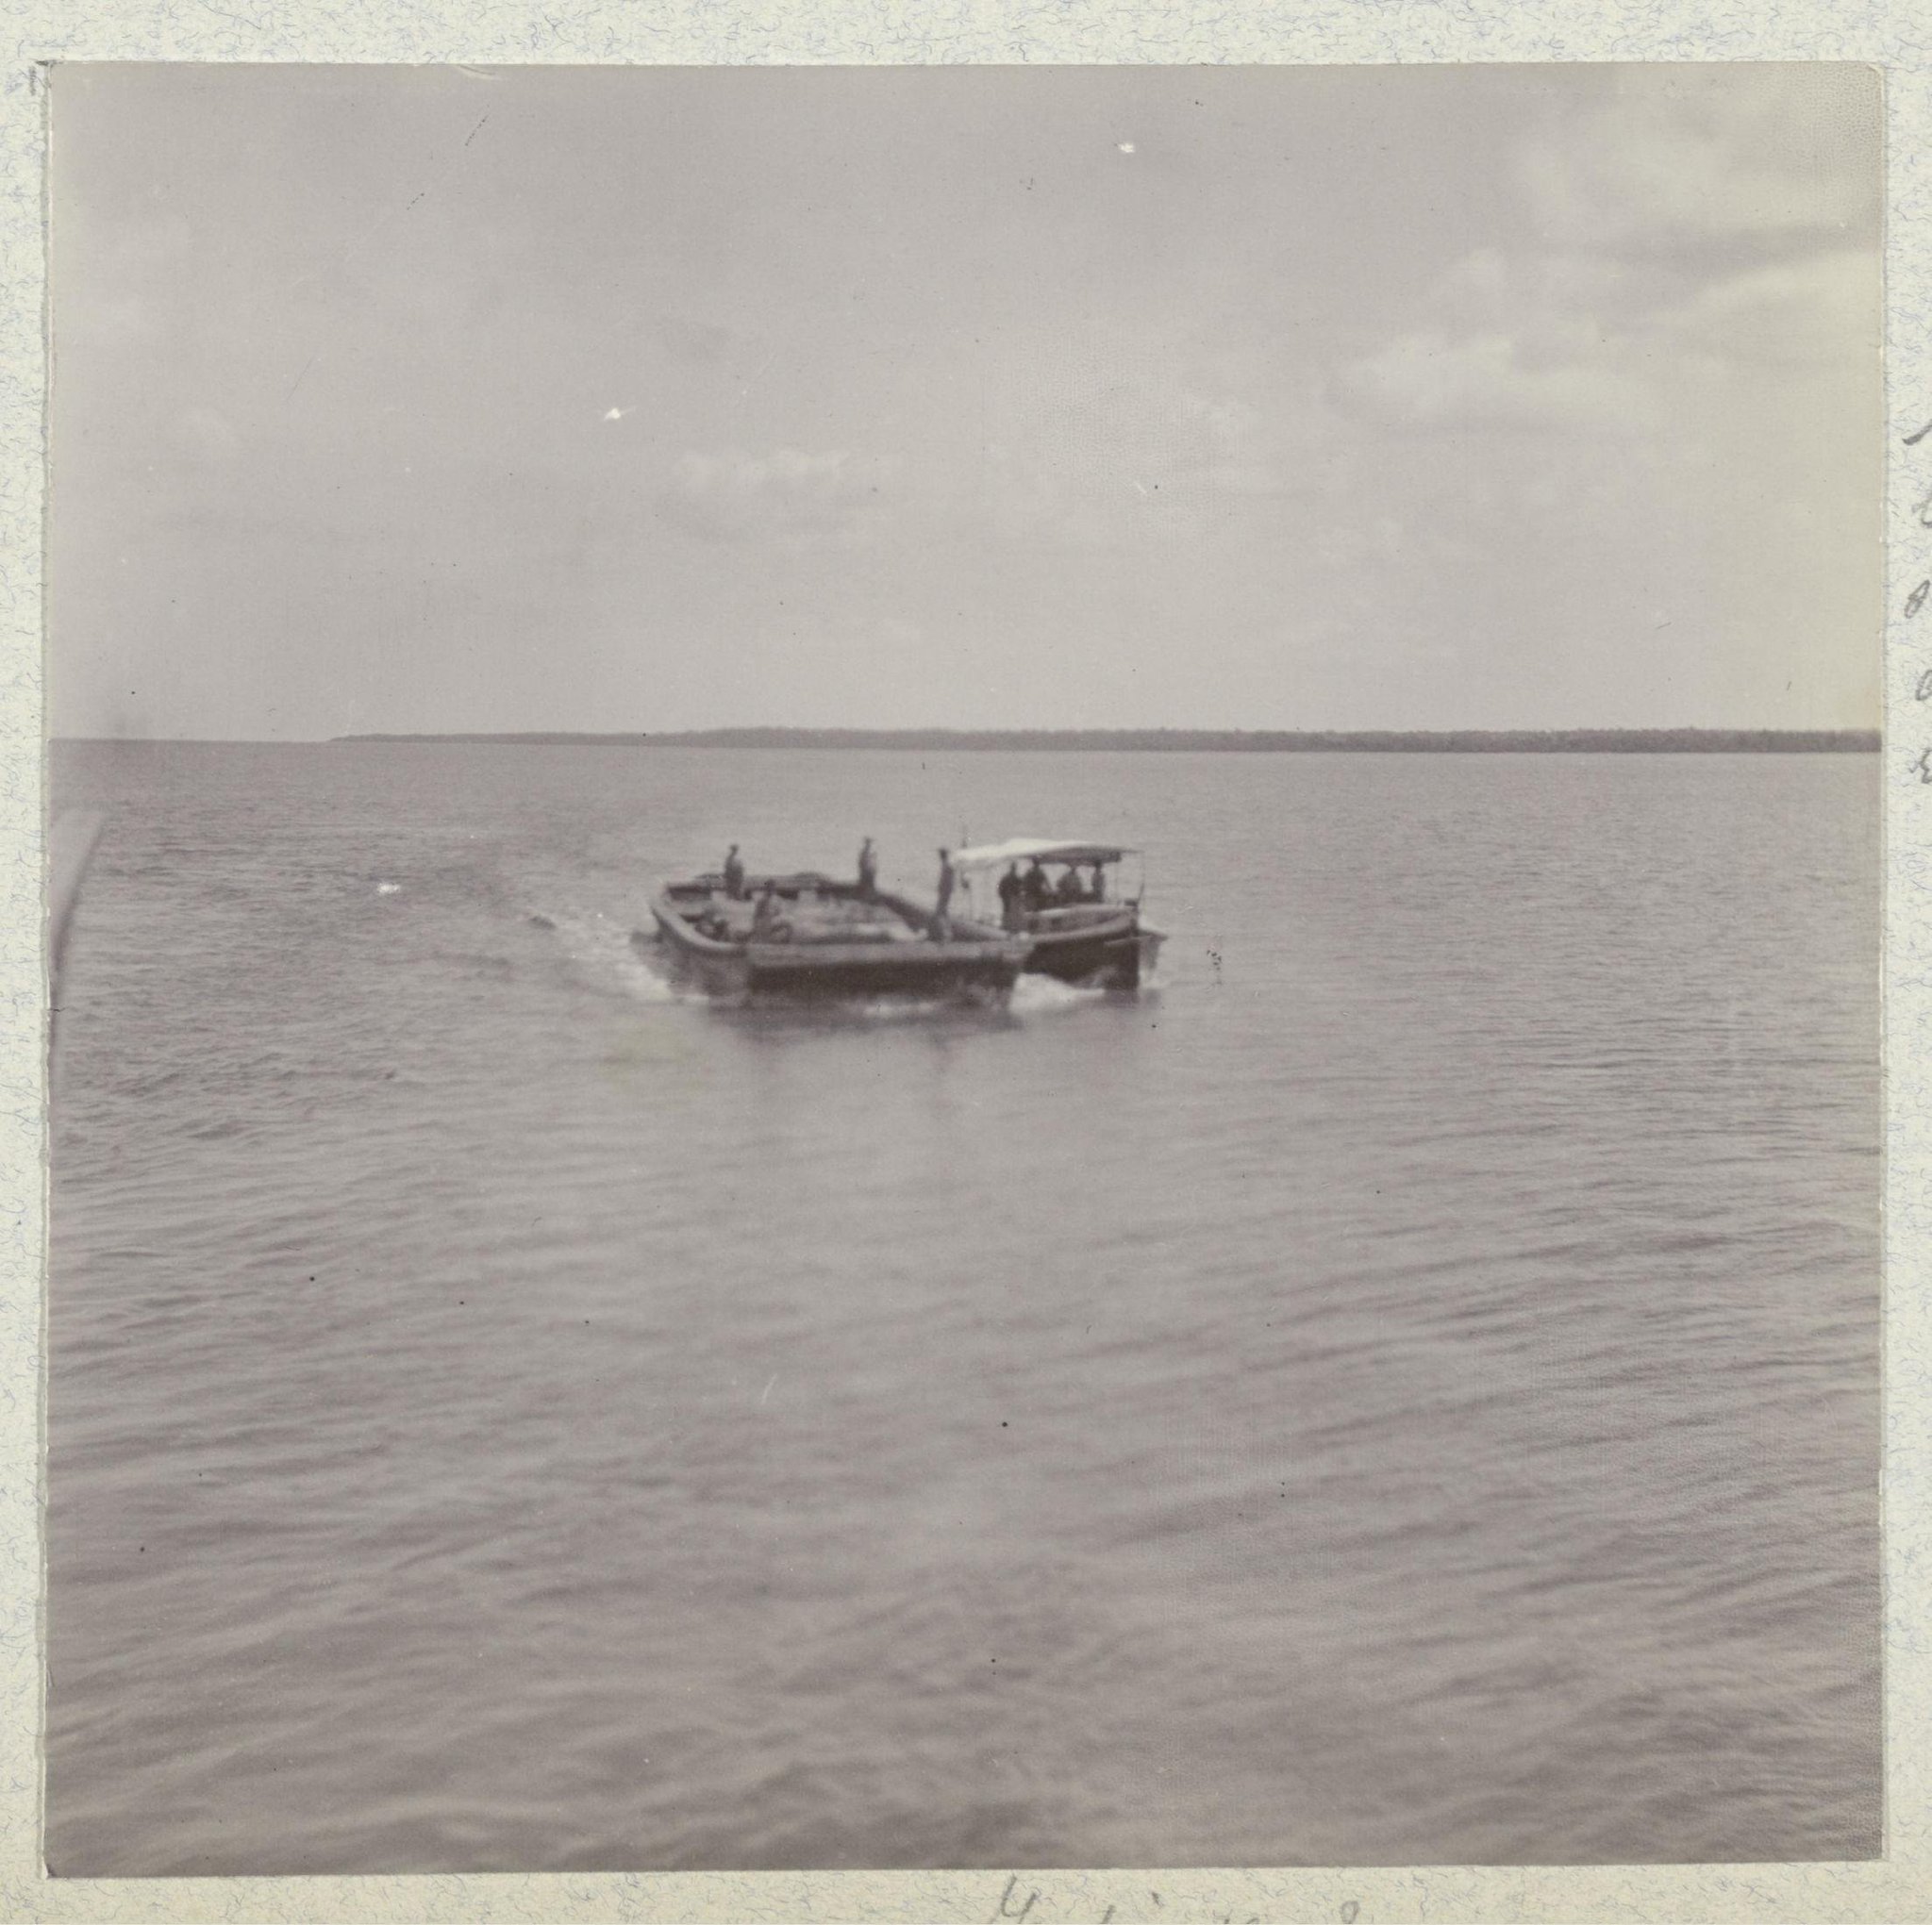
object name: photograph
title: Boten op de Suriname rivier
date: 1907-1908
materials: photographic support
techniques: photography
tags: amsterdam, andries augustus boom, river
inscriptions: inscription: ‘Motorboot en lichter v.d. ... stroomafwaarts de Suriname rivier sleepende’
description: Boten op de Suriname rivier, juli 1908. Onderdeel van het fotoalbum van de familie Boom-Gonggrijp in Suriname en Curaçao.